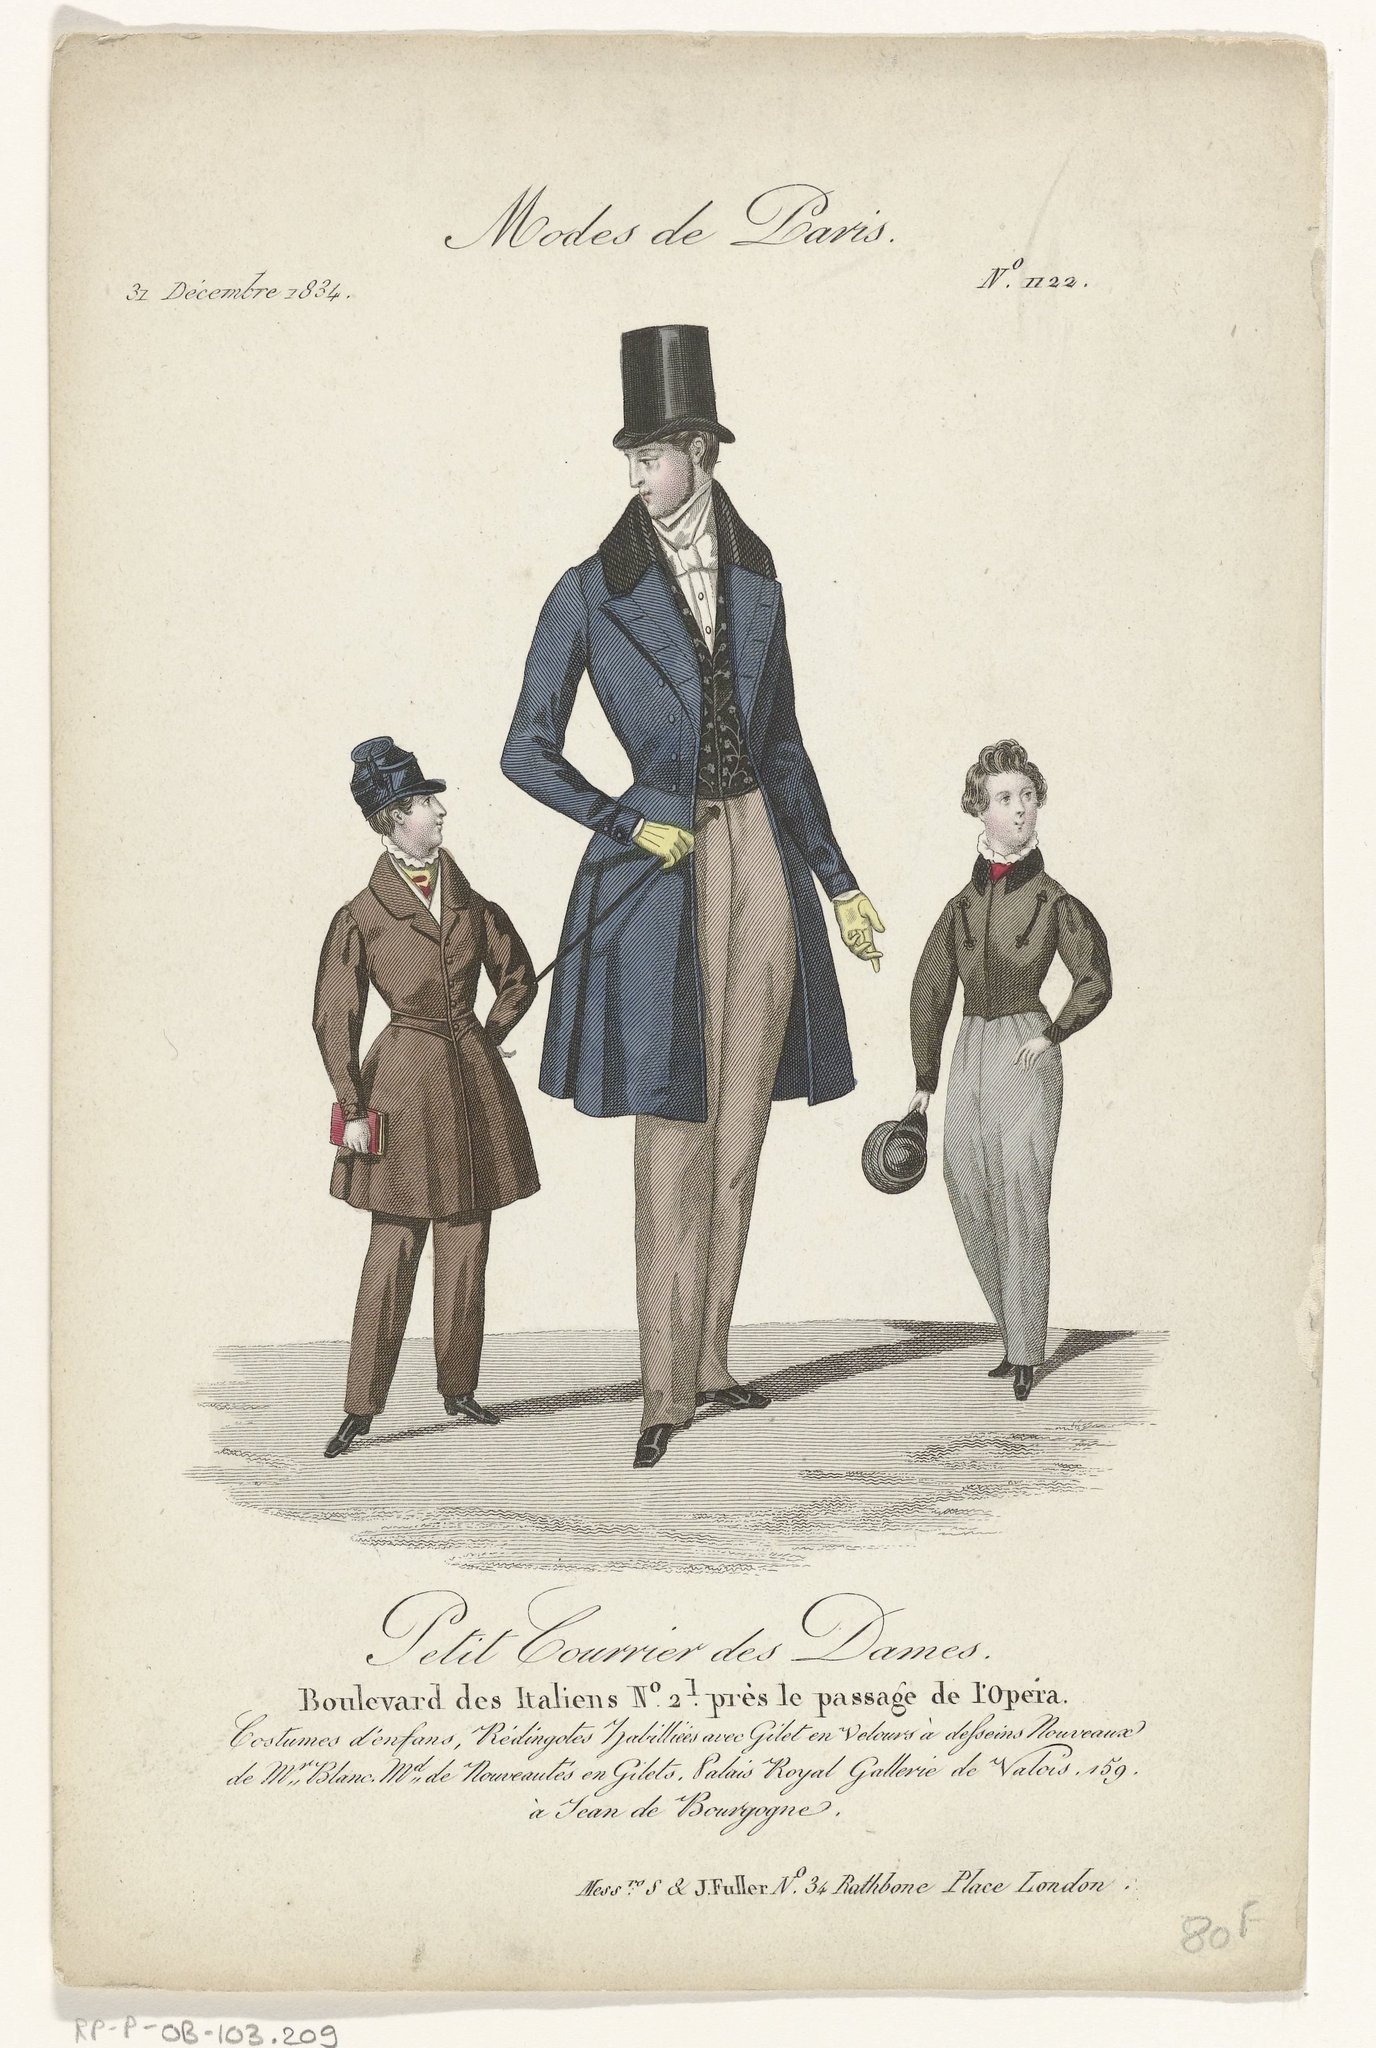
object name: fashion print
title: Petit Courrier des Dames, 31 décembre, 1834, No. 1122 : Costumes d'enfans (...)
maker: Anonymous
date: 1834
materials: paper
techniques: engraving, hand coloring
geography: london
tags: clothing for the upper part of the body (vest) (+ men's clothes), trousers, breeches (+ boys' clothes), head-gear: hat (+ boys' clothes), trousers, breeches (+ men's clothes), coat (+ men's clothes), coat (+ boys' clothes), fashion plates, walking-stick, staff, cane (+ men's clothes)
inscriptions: address: ‘Boulevard des Italiens No. 2 1 près le passage de l'Opéra. / Mess.rs S & J. Fuller No. 34 Rathbone Place London.’, title: ‘Modes de Paris’, title: ‘Petit Courrier des Dames.’, caption: ‘Costumes d'enfans, Rédingotes habilliées avec Gilet en Velours à desseins Nouveaux de Mr Blanc. Md de Nouveatés en Gilets. Palais Royal Gallerie de Valois, 159, à Jean de Bourgogne.’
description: Kinderkleding. 'Redingotes habillées' met vest van fluweel met nieuwe dessins van Mr Blanc, 'Md Nouveautés en Gilets'. Prent uit het modetijdschrift Petit Courrier des Dames (1821-1868).